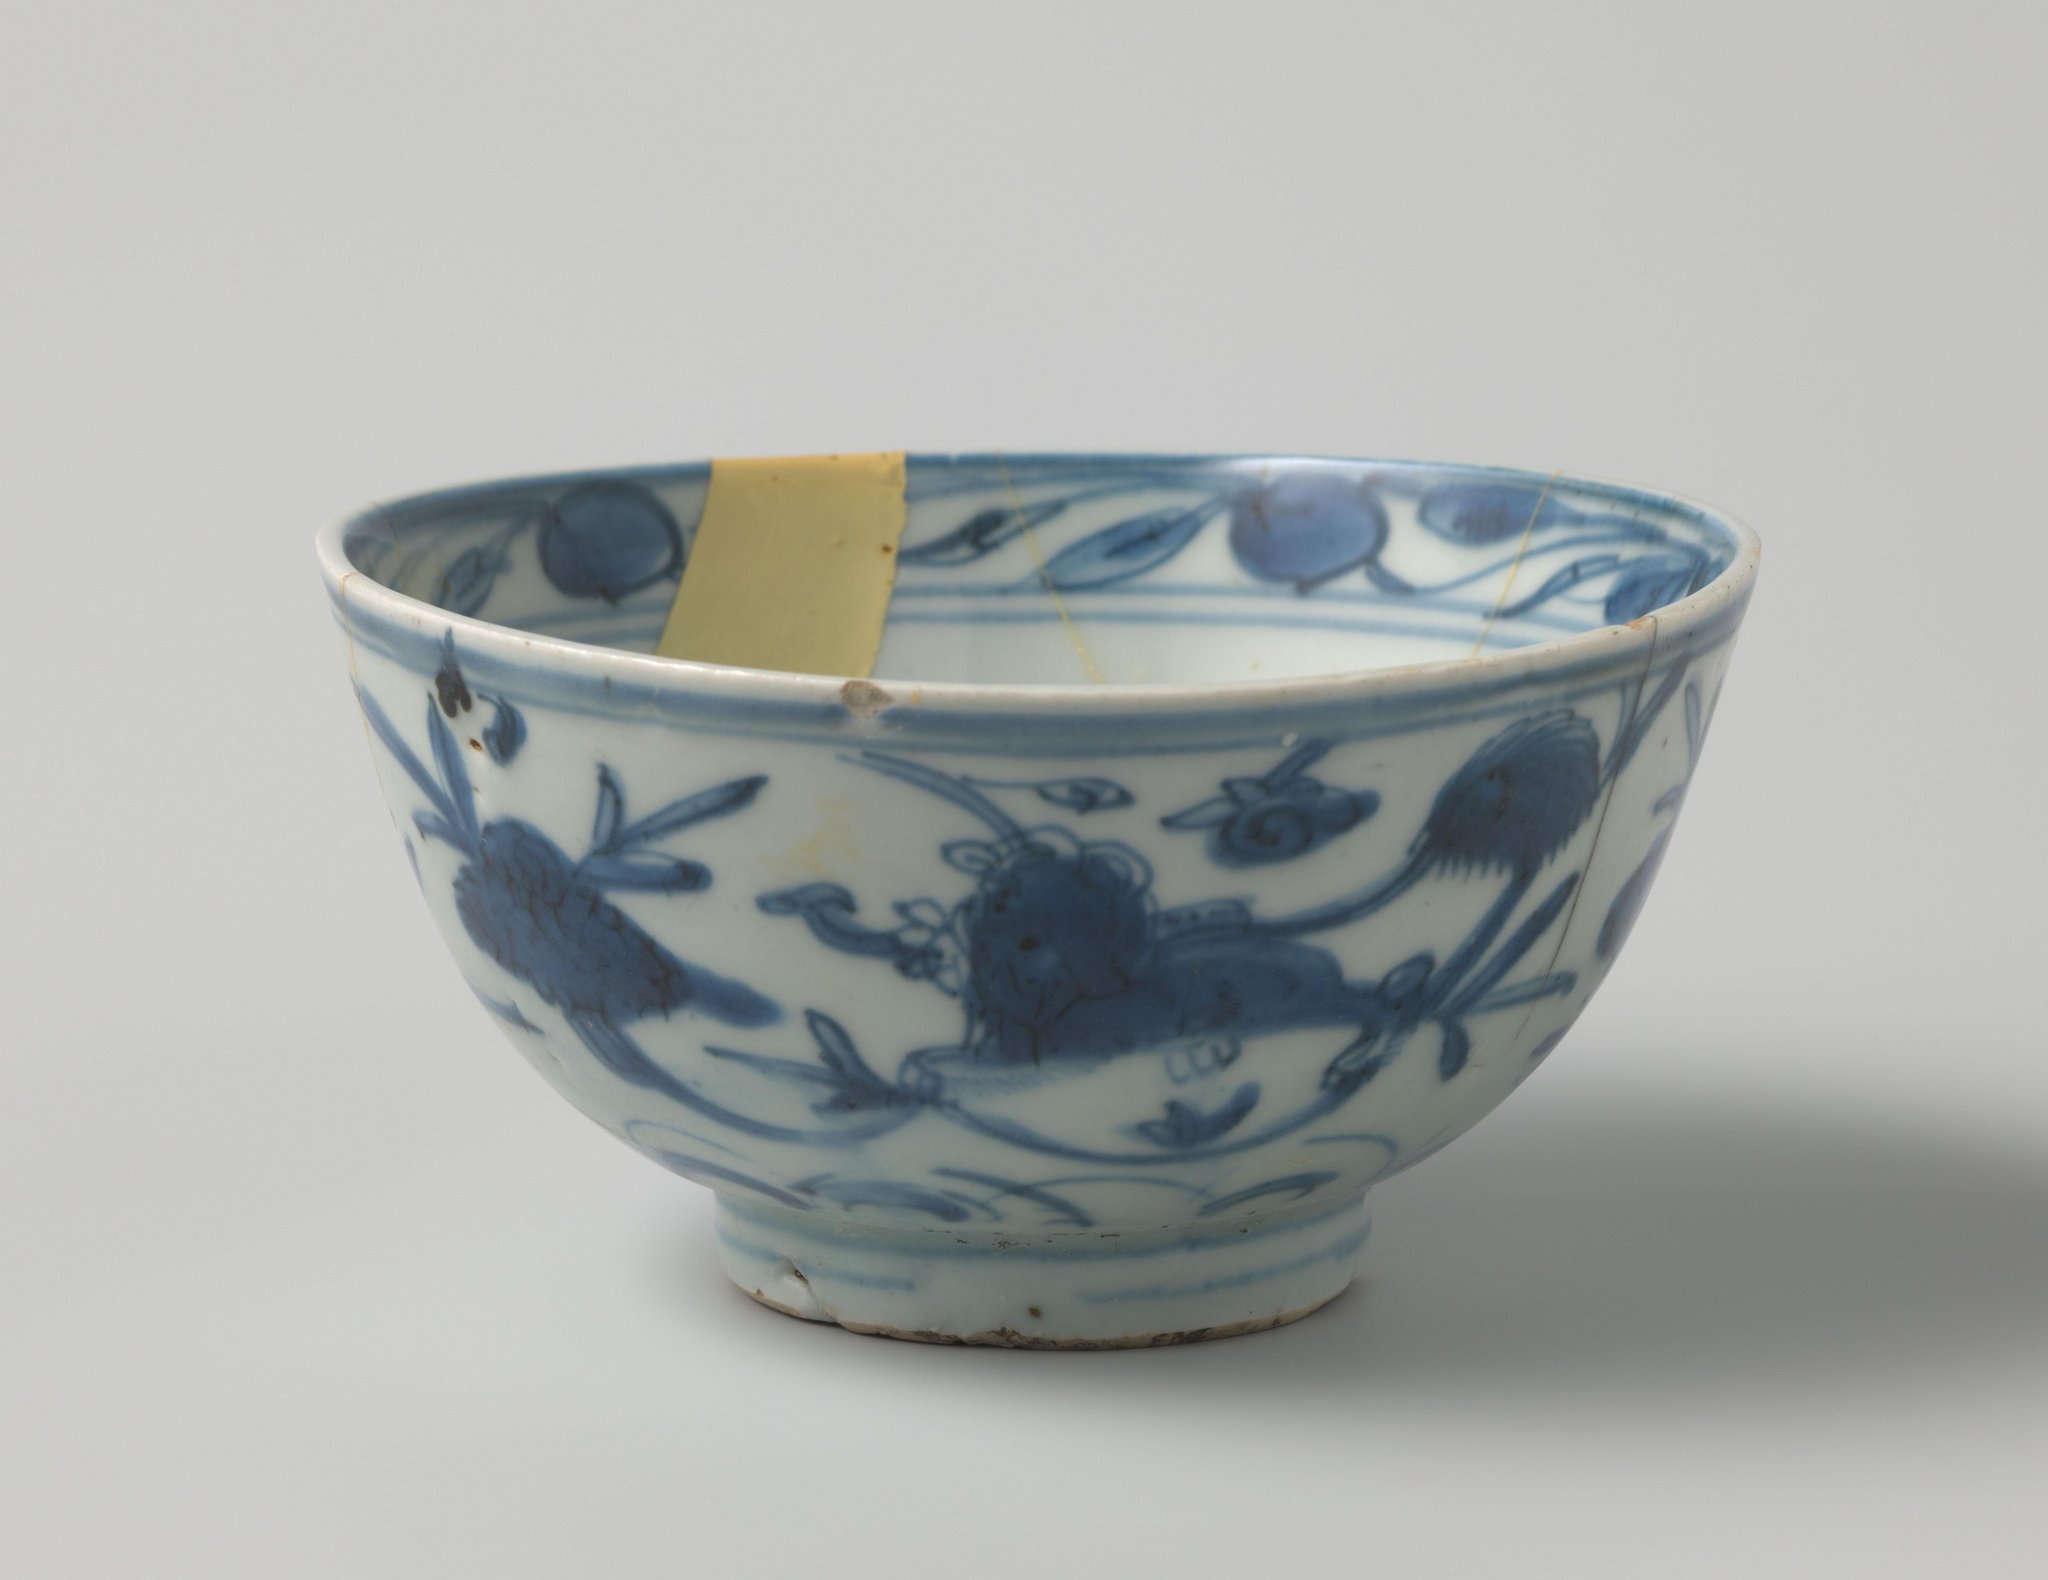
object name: bowl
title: Kom uit V.O.C.-schip de 'Witte Leeuw'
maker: Anonymous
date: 1613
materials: porcelain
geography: jingdezhen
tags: verenigde oostindische compagnie, sint-helena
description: A bowl. In the centre a motive is drawn encircled by a band of short lotus panels. On the lip-rim a frieze of peaches with leaves is drawn. The outside wall is decorated with alternating twice: a lion dog (fu) and a scroll of peonies. Around the footring a band of half-circles is drawn.